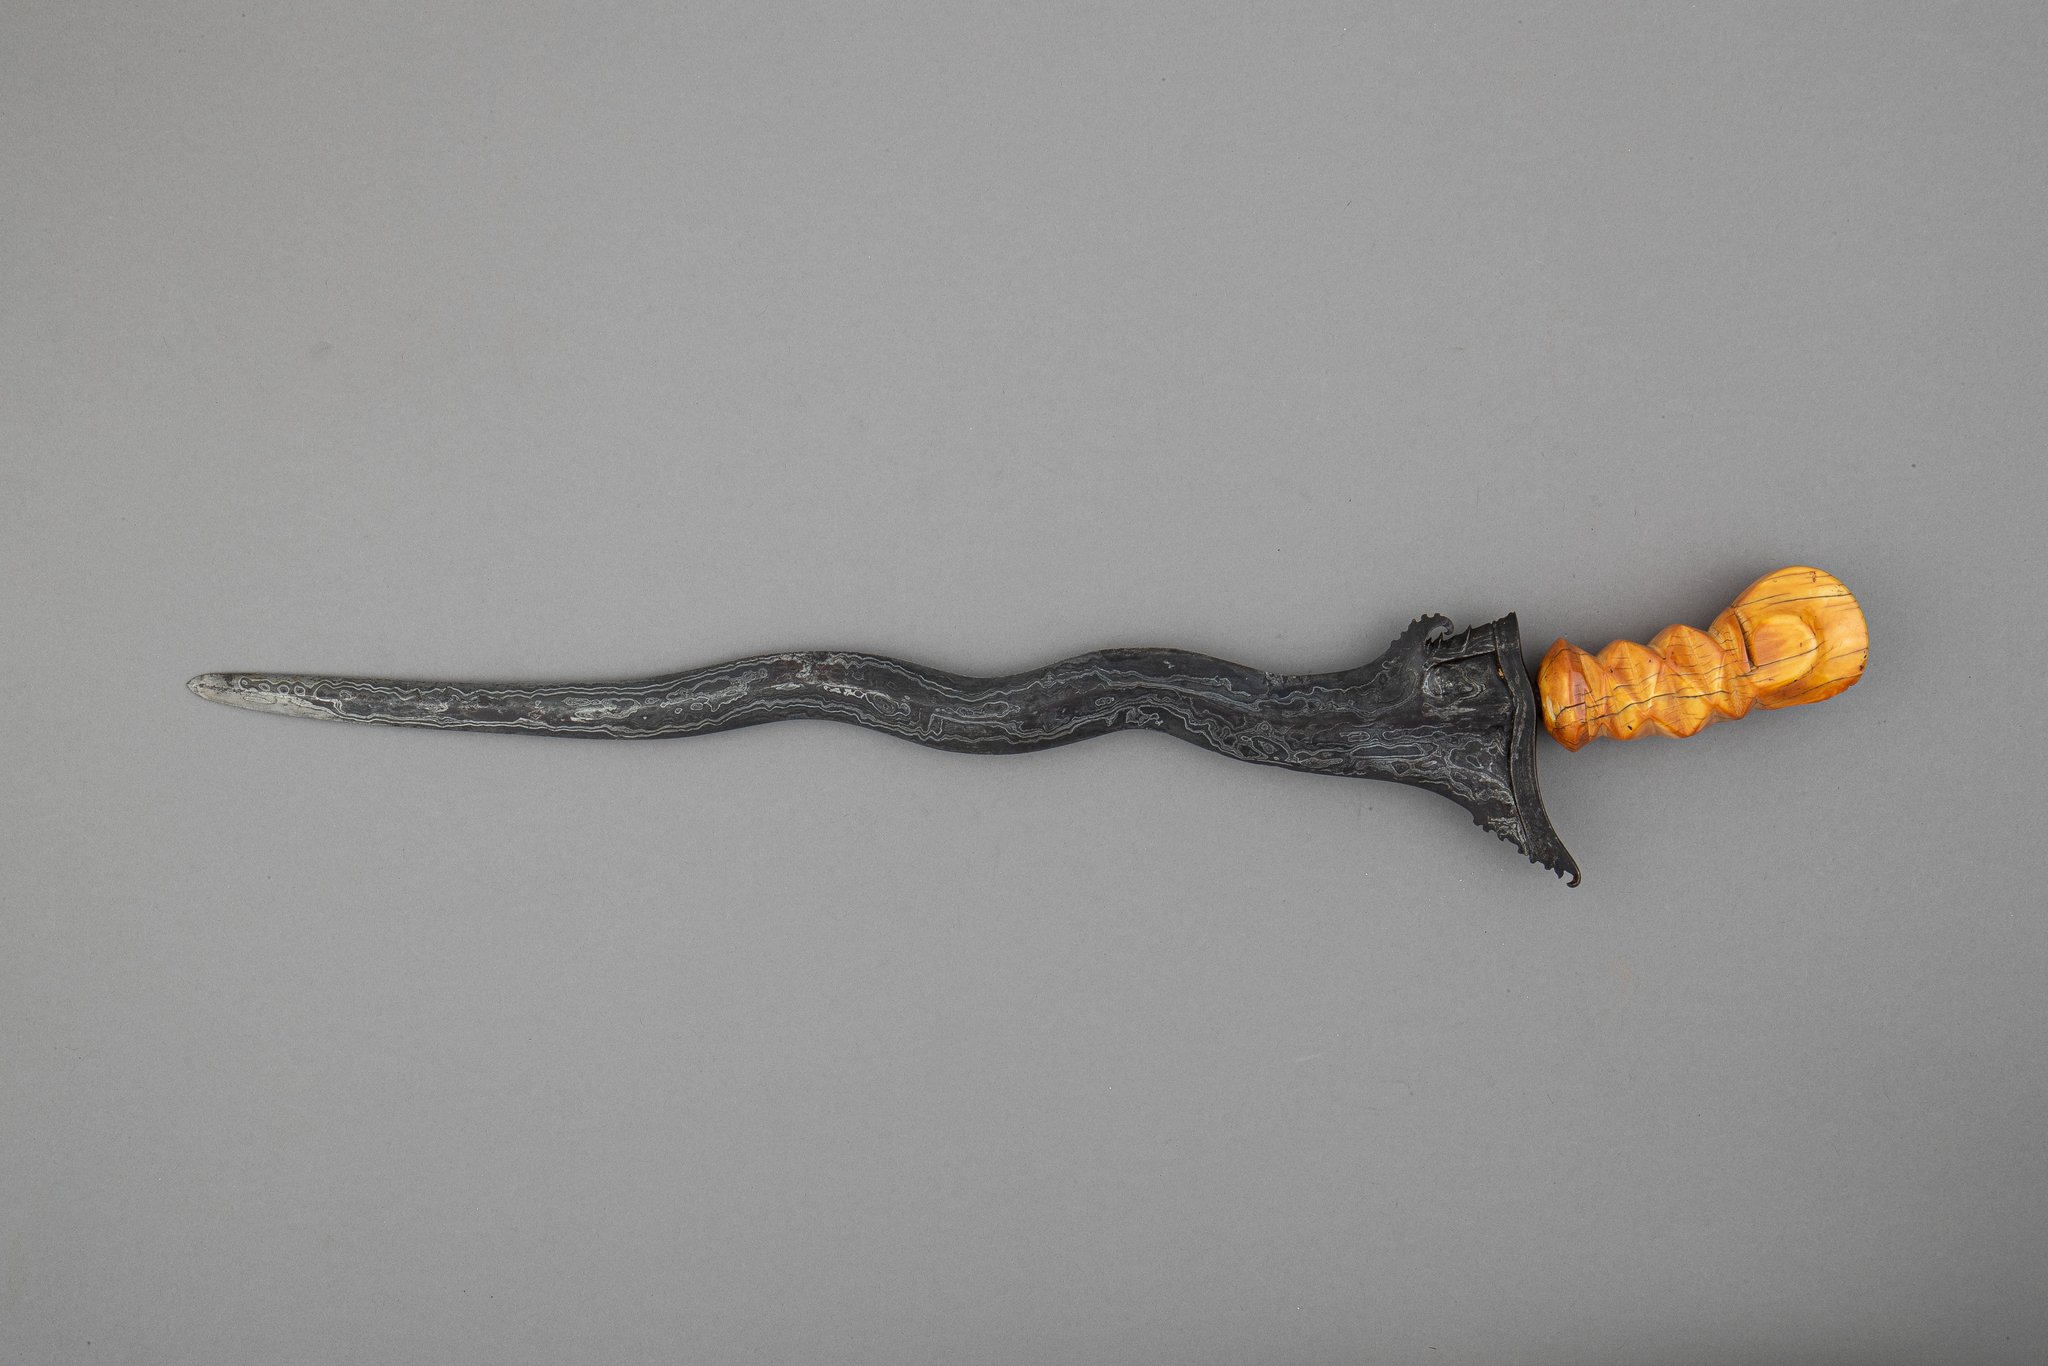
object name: kris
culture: balinese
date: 1501-1900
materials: ivory, steel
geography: indonesia